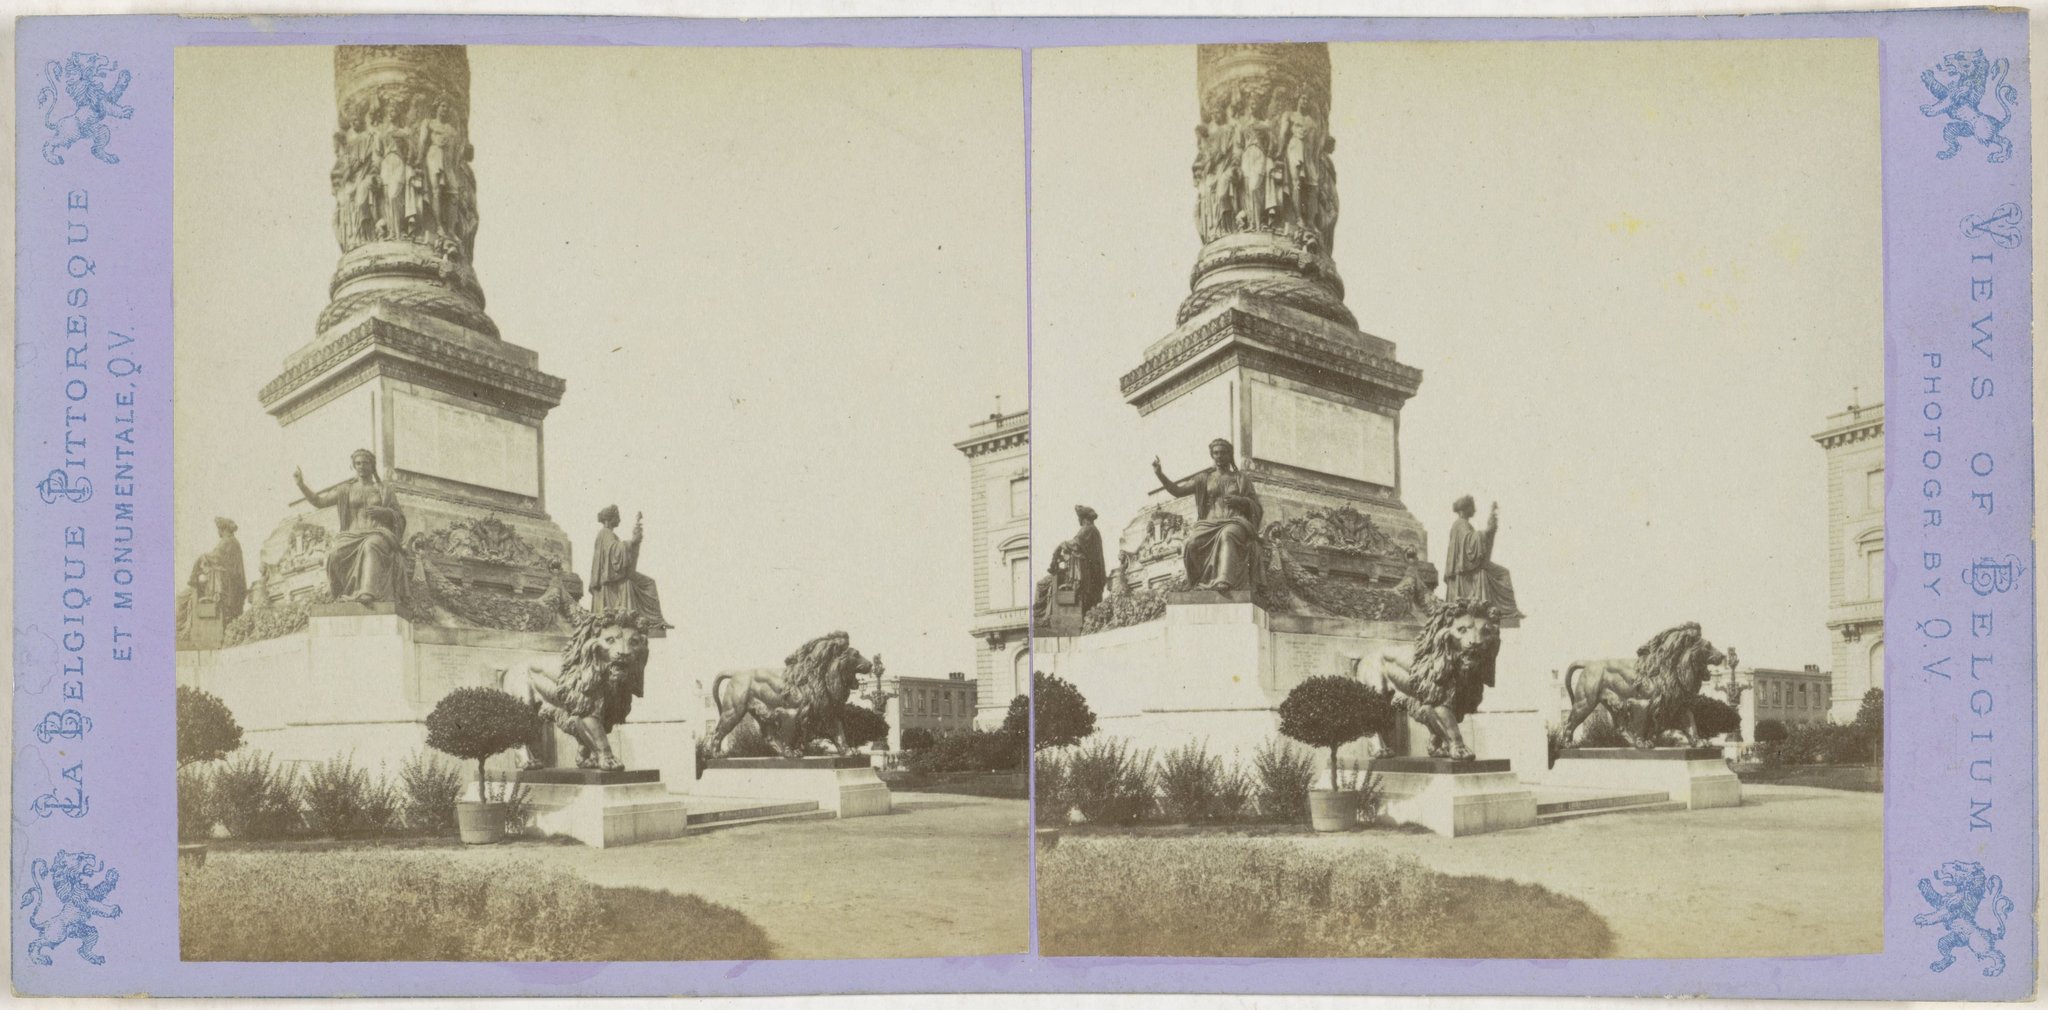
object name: stereograph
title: La Belgique pittoresque et monumentale / Views of Belgium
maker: jules hippolyte quéval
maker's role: publisher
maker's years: 1824-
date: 1866-1870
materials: cardboard, paper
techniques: albumen print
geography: brussels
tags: monument, statue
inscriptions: number: ‘No 1622’